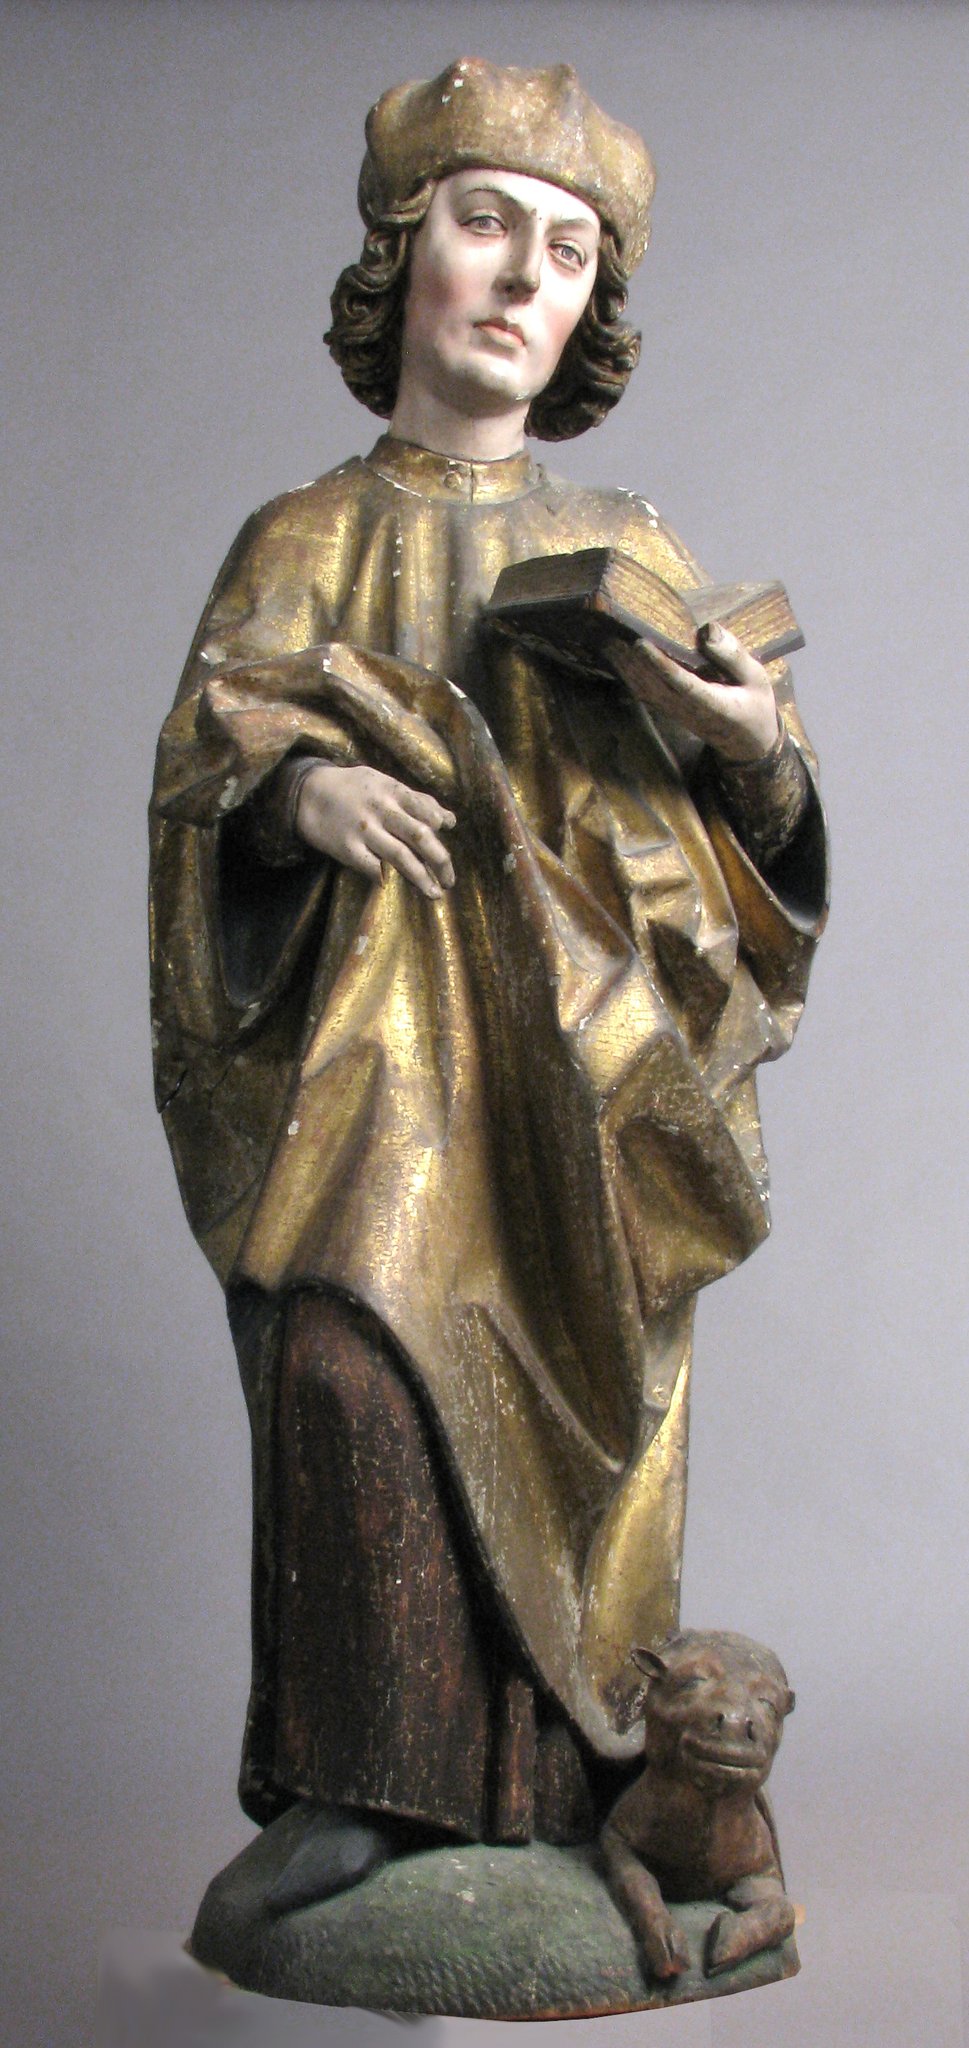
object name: wall statue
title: Saint Luke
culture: german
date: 1467-1500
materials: wood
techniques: gilding, polychromy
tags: saint luke